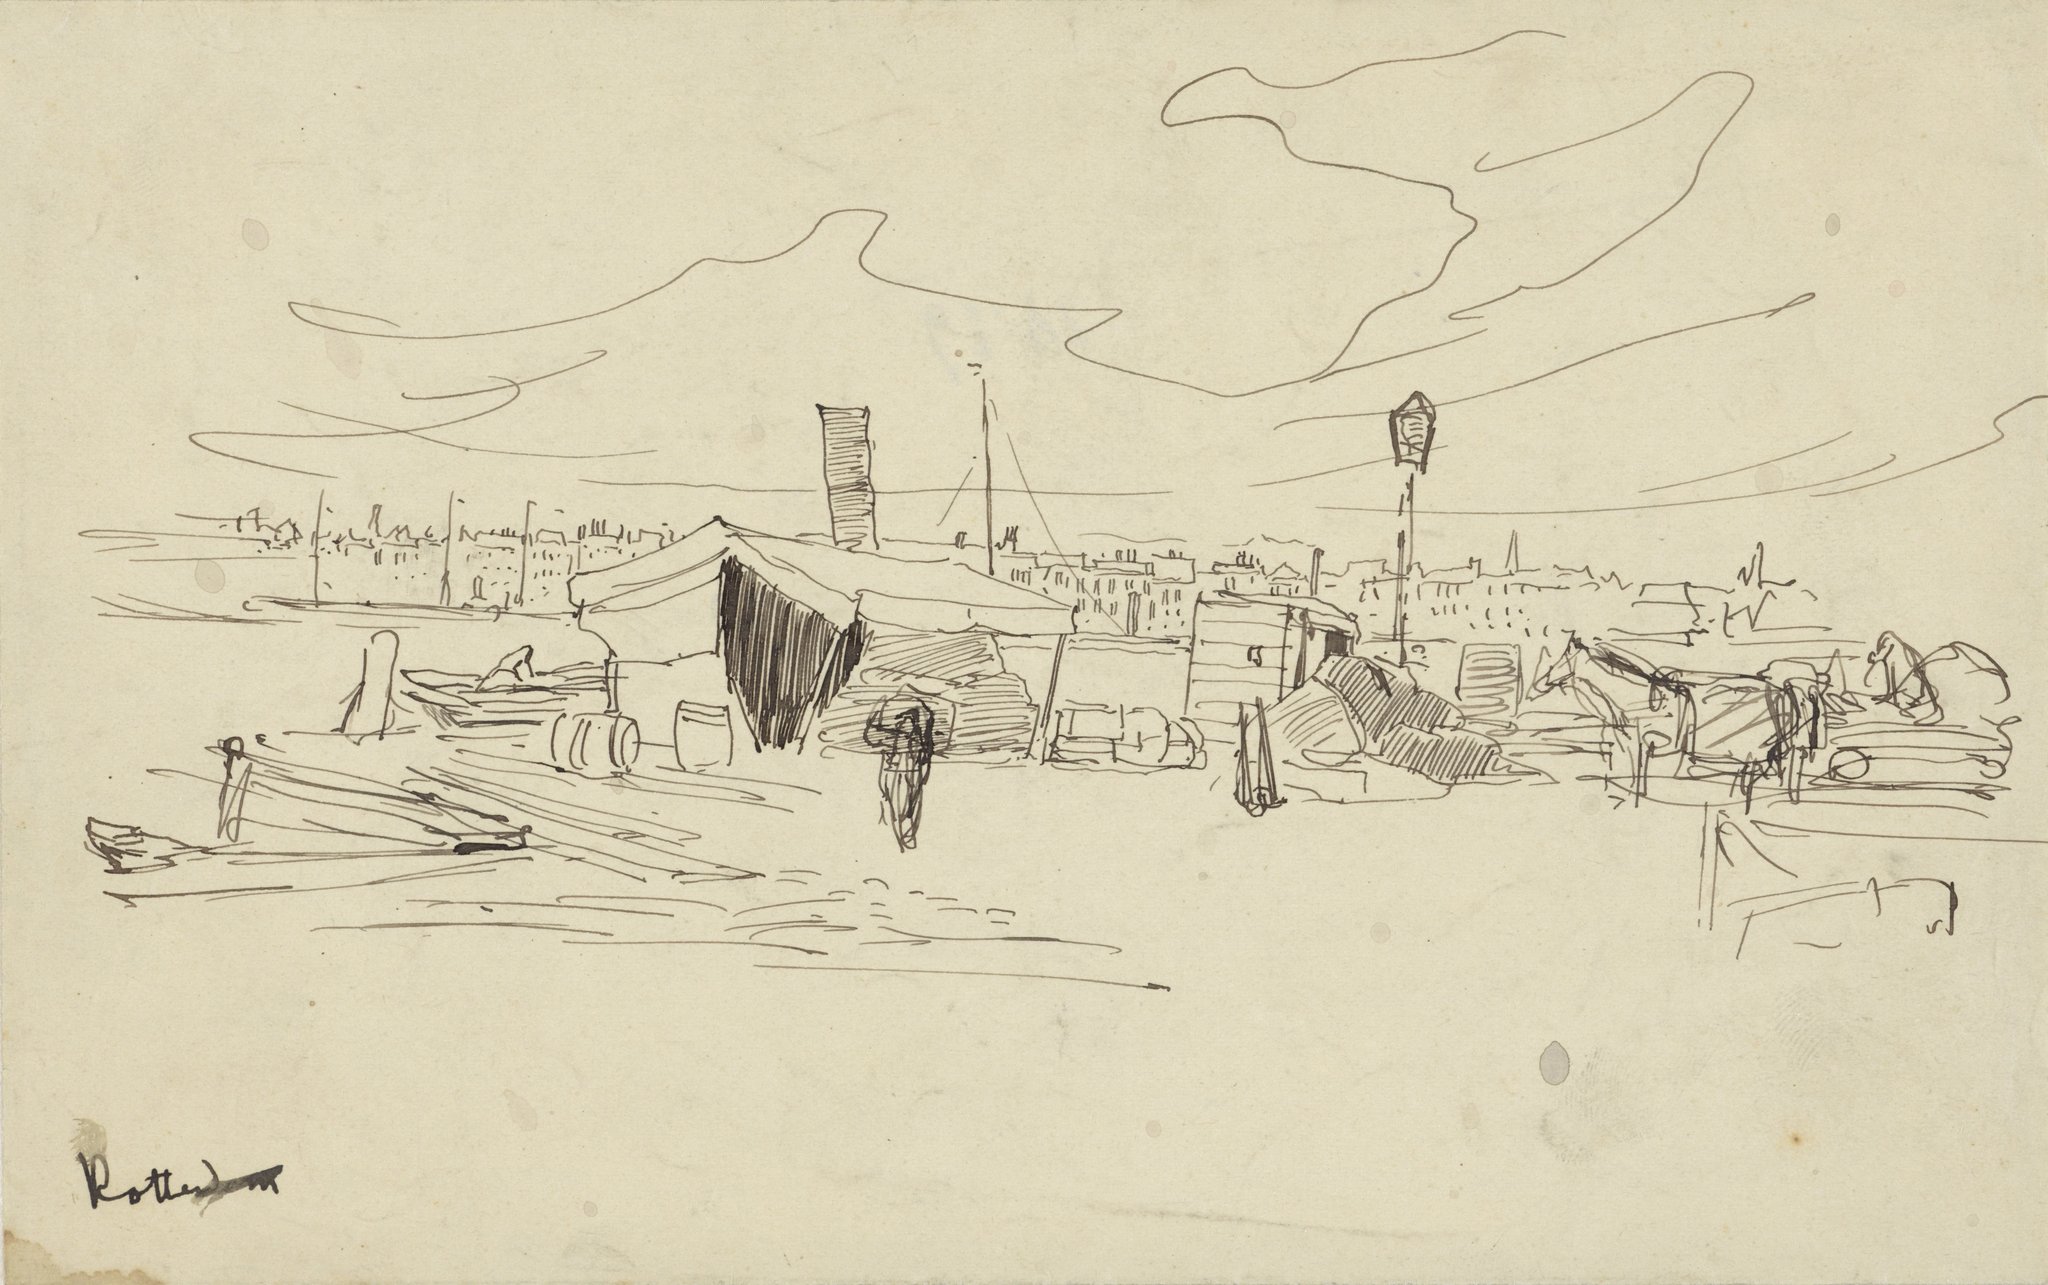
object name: drawing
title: Havengezicht te Rotterdam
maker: adolf le comte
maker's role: draughtsman, painter, print maker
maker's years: 1850-1921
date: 1860-1921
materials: ink, paper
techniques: pen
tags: harbour, rotterdam